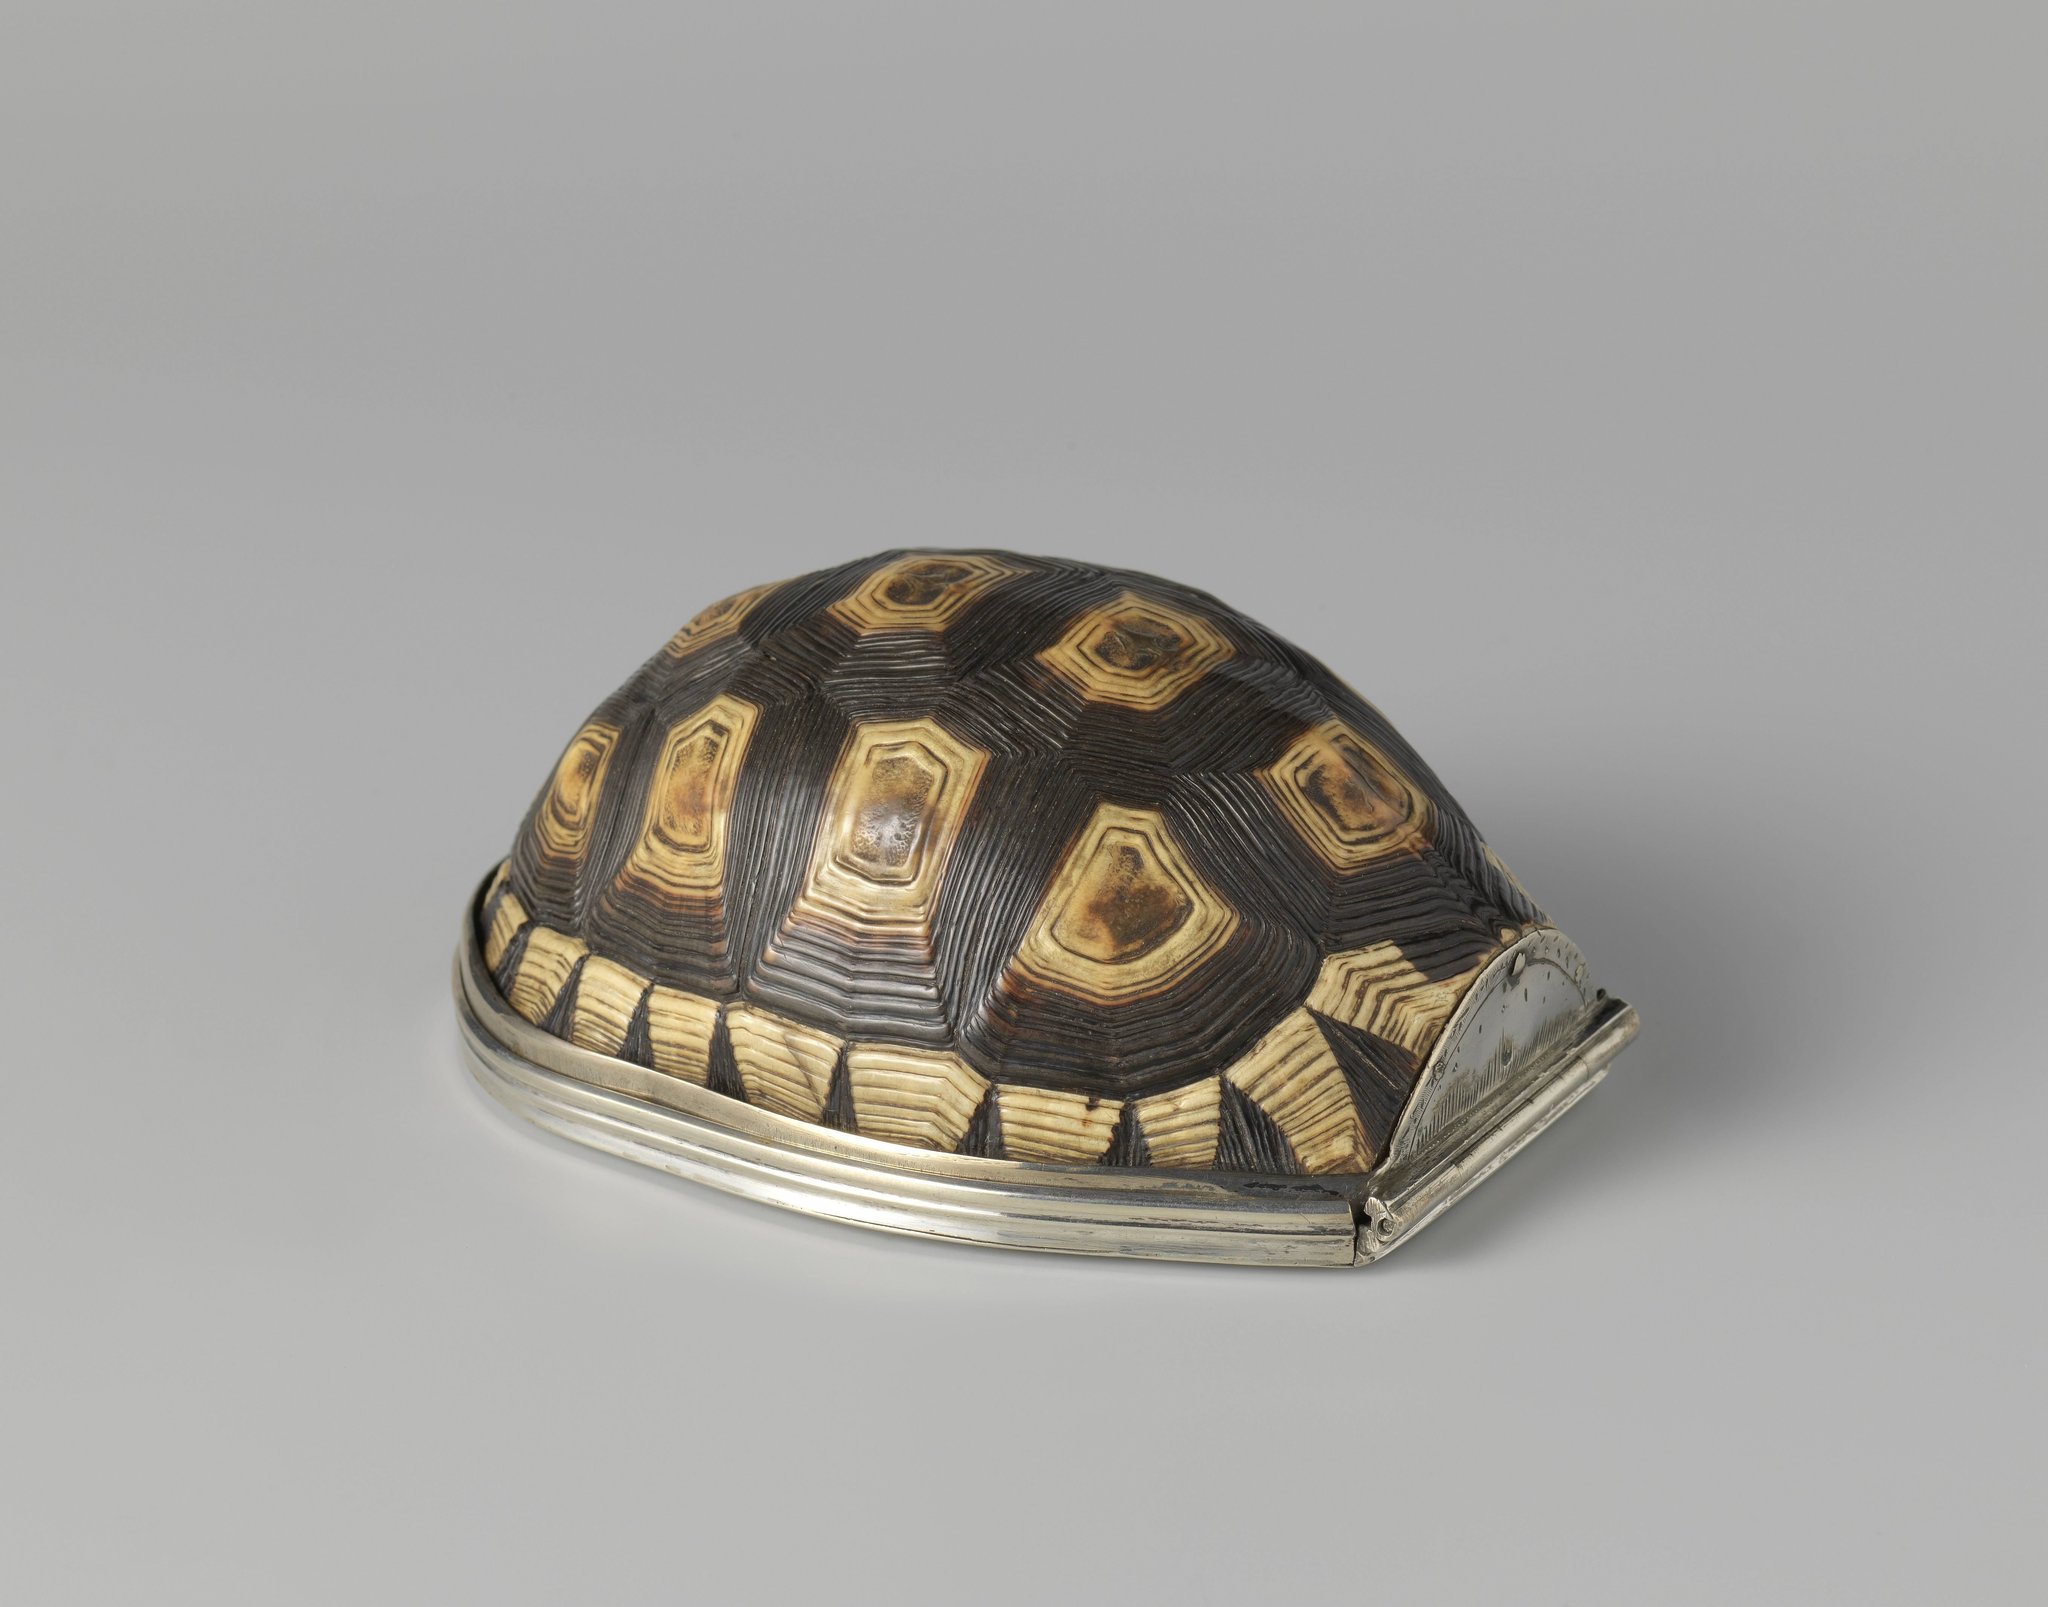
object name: tobacco box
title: Tabaksdoos van een schildpadschild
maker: Anonymous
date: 1785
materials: silver, shell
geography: netherlands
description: Tobacco box. Tortoiseshell and silver. Netherlands, c. 1785.